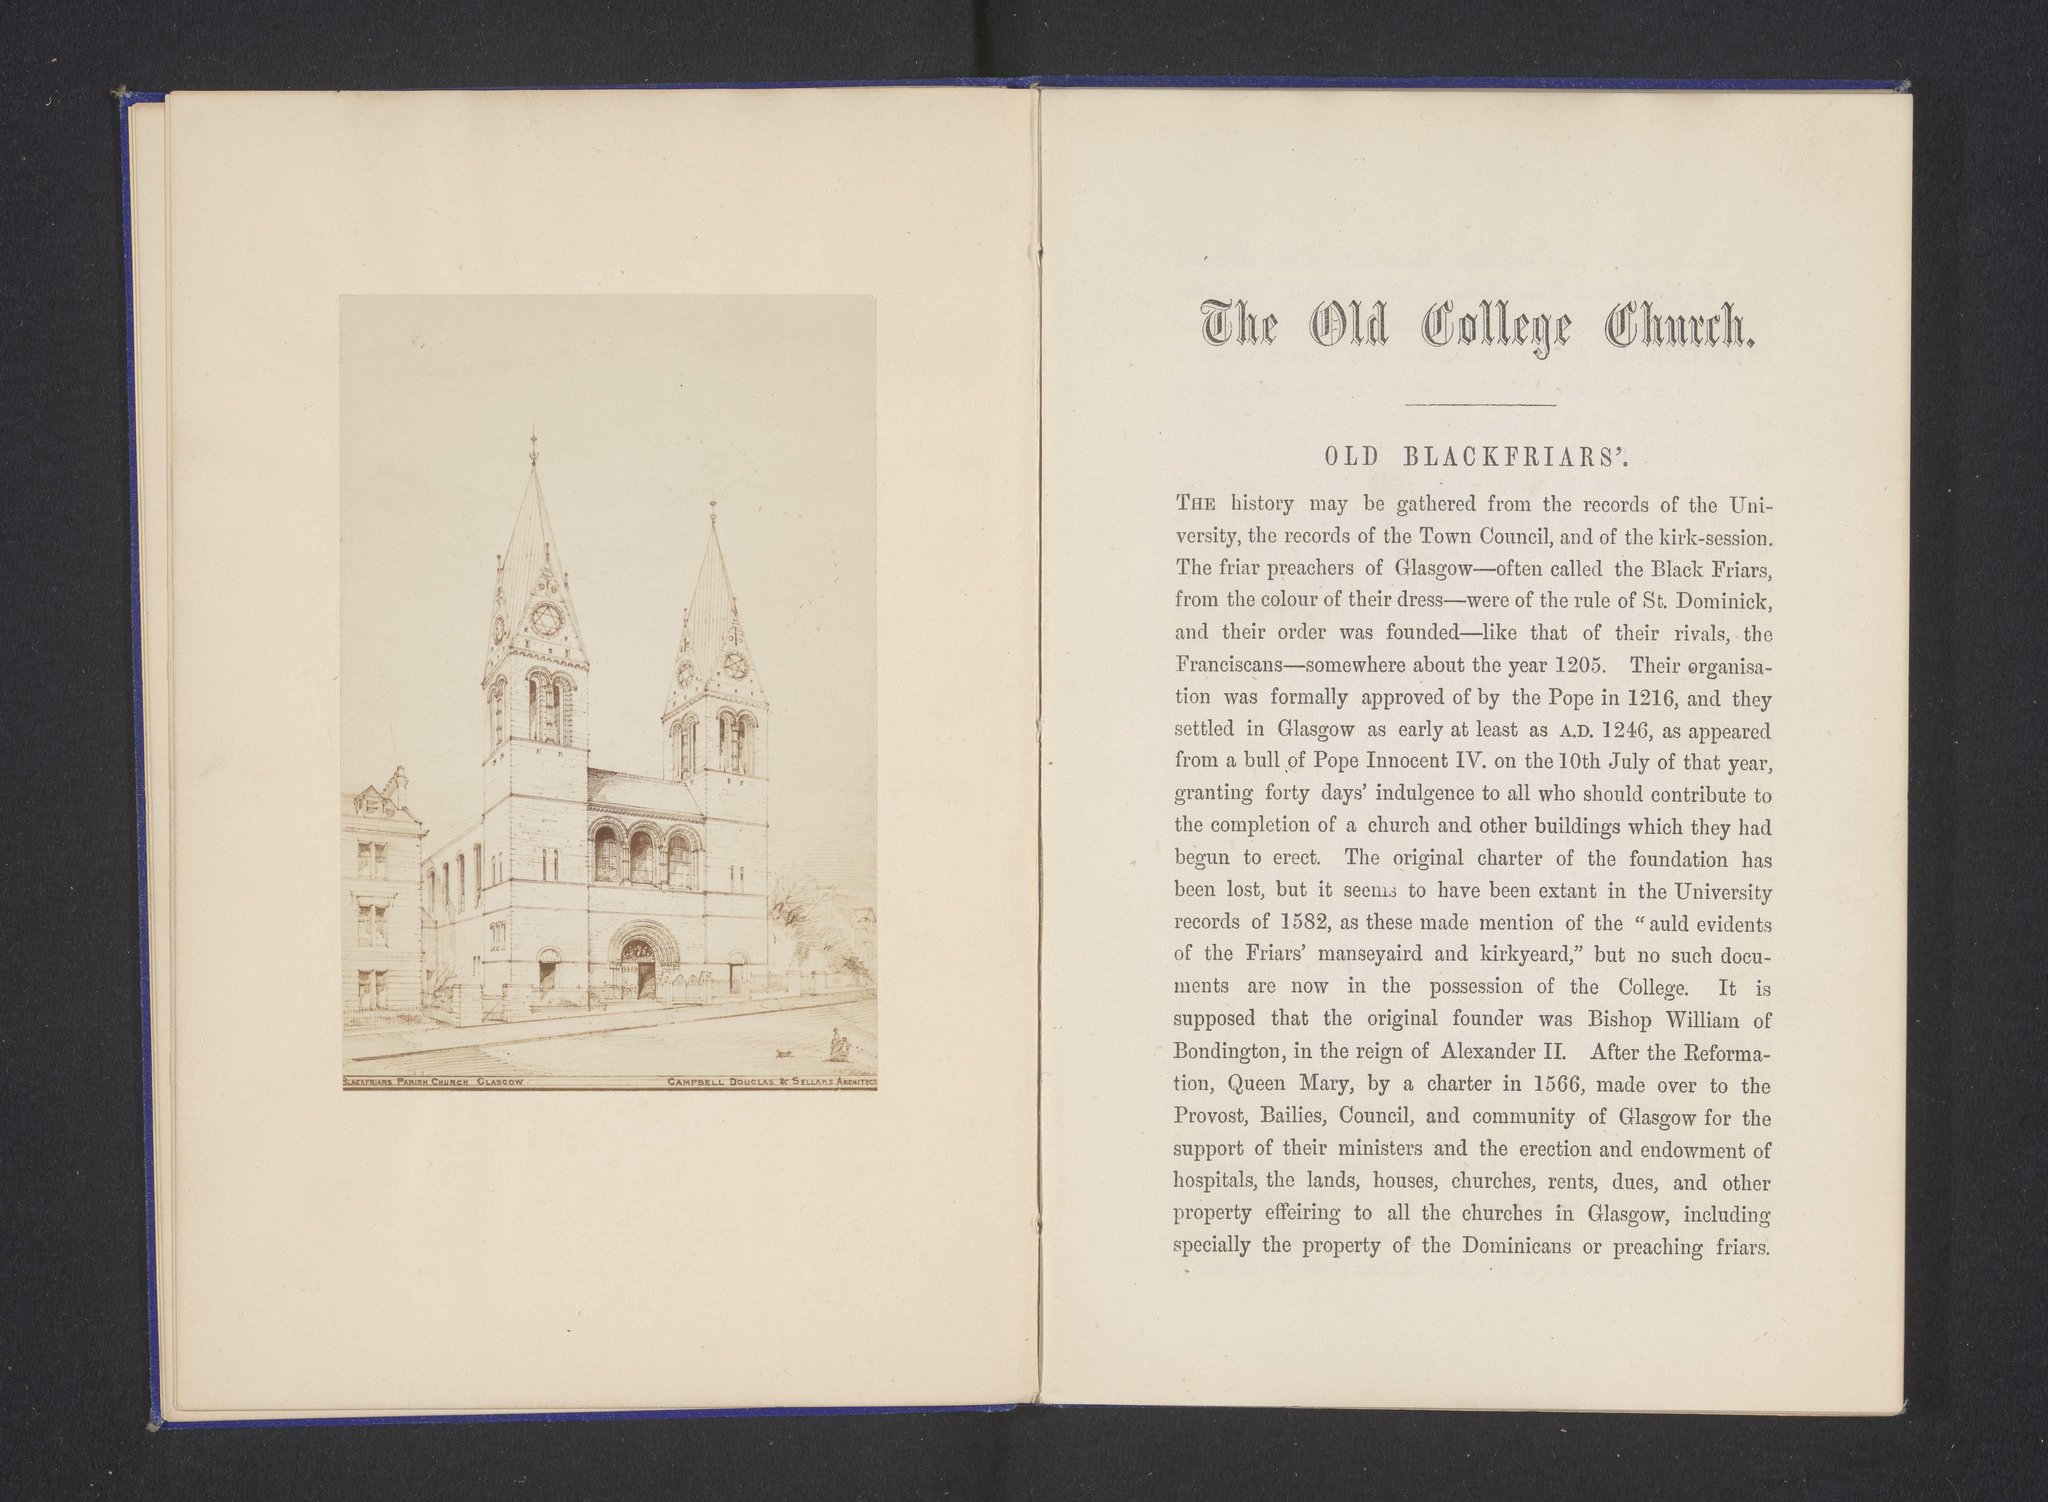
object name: reproduction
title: Fotoreproductie van een tekening van de Old College Church in Glasgow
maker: Anonymous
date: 1866-1876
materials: photographic support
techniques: albumen print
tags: drawing, sketch, church (exterior), glasgow